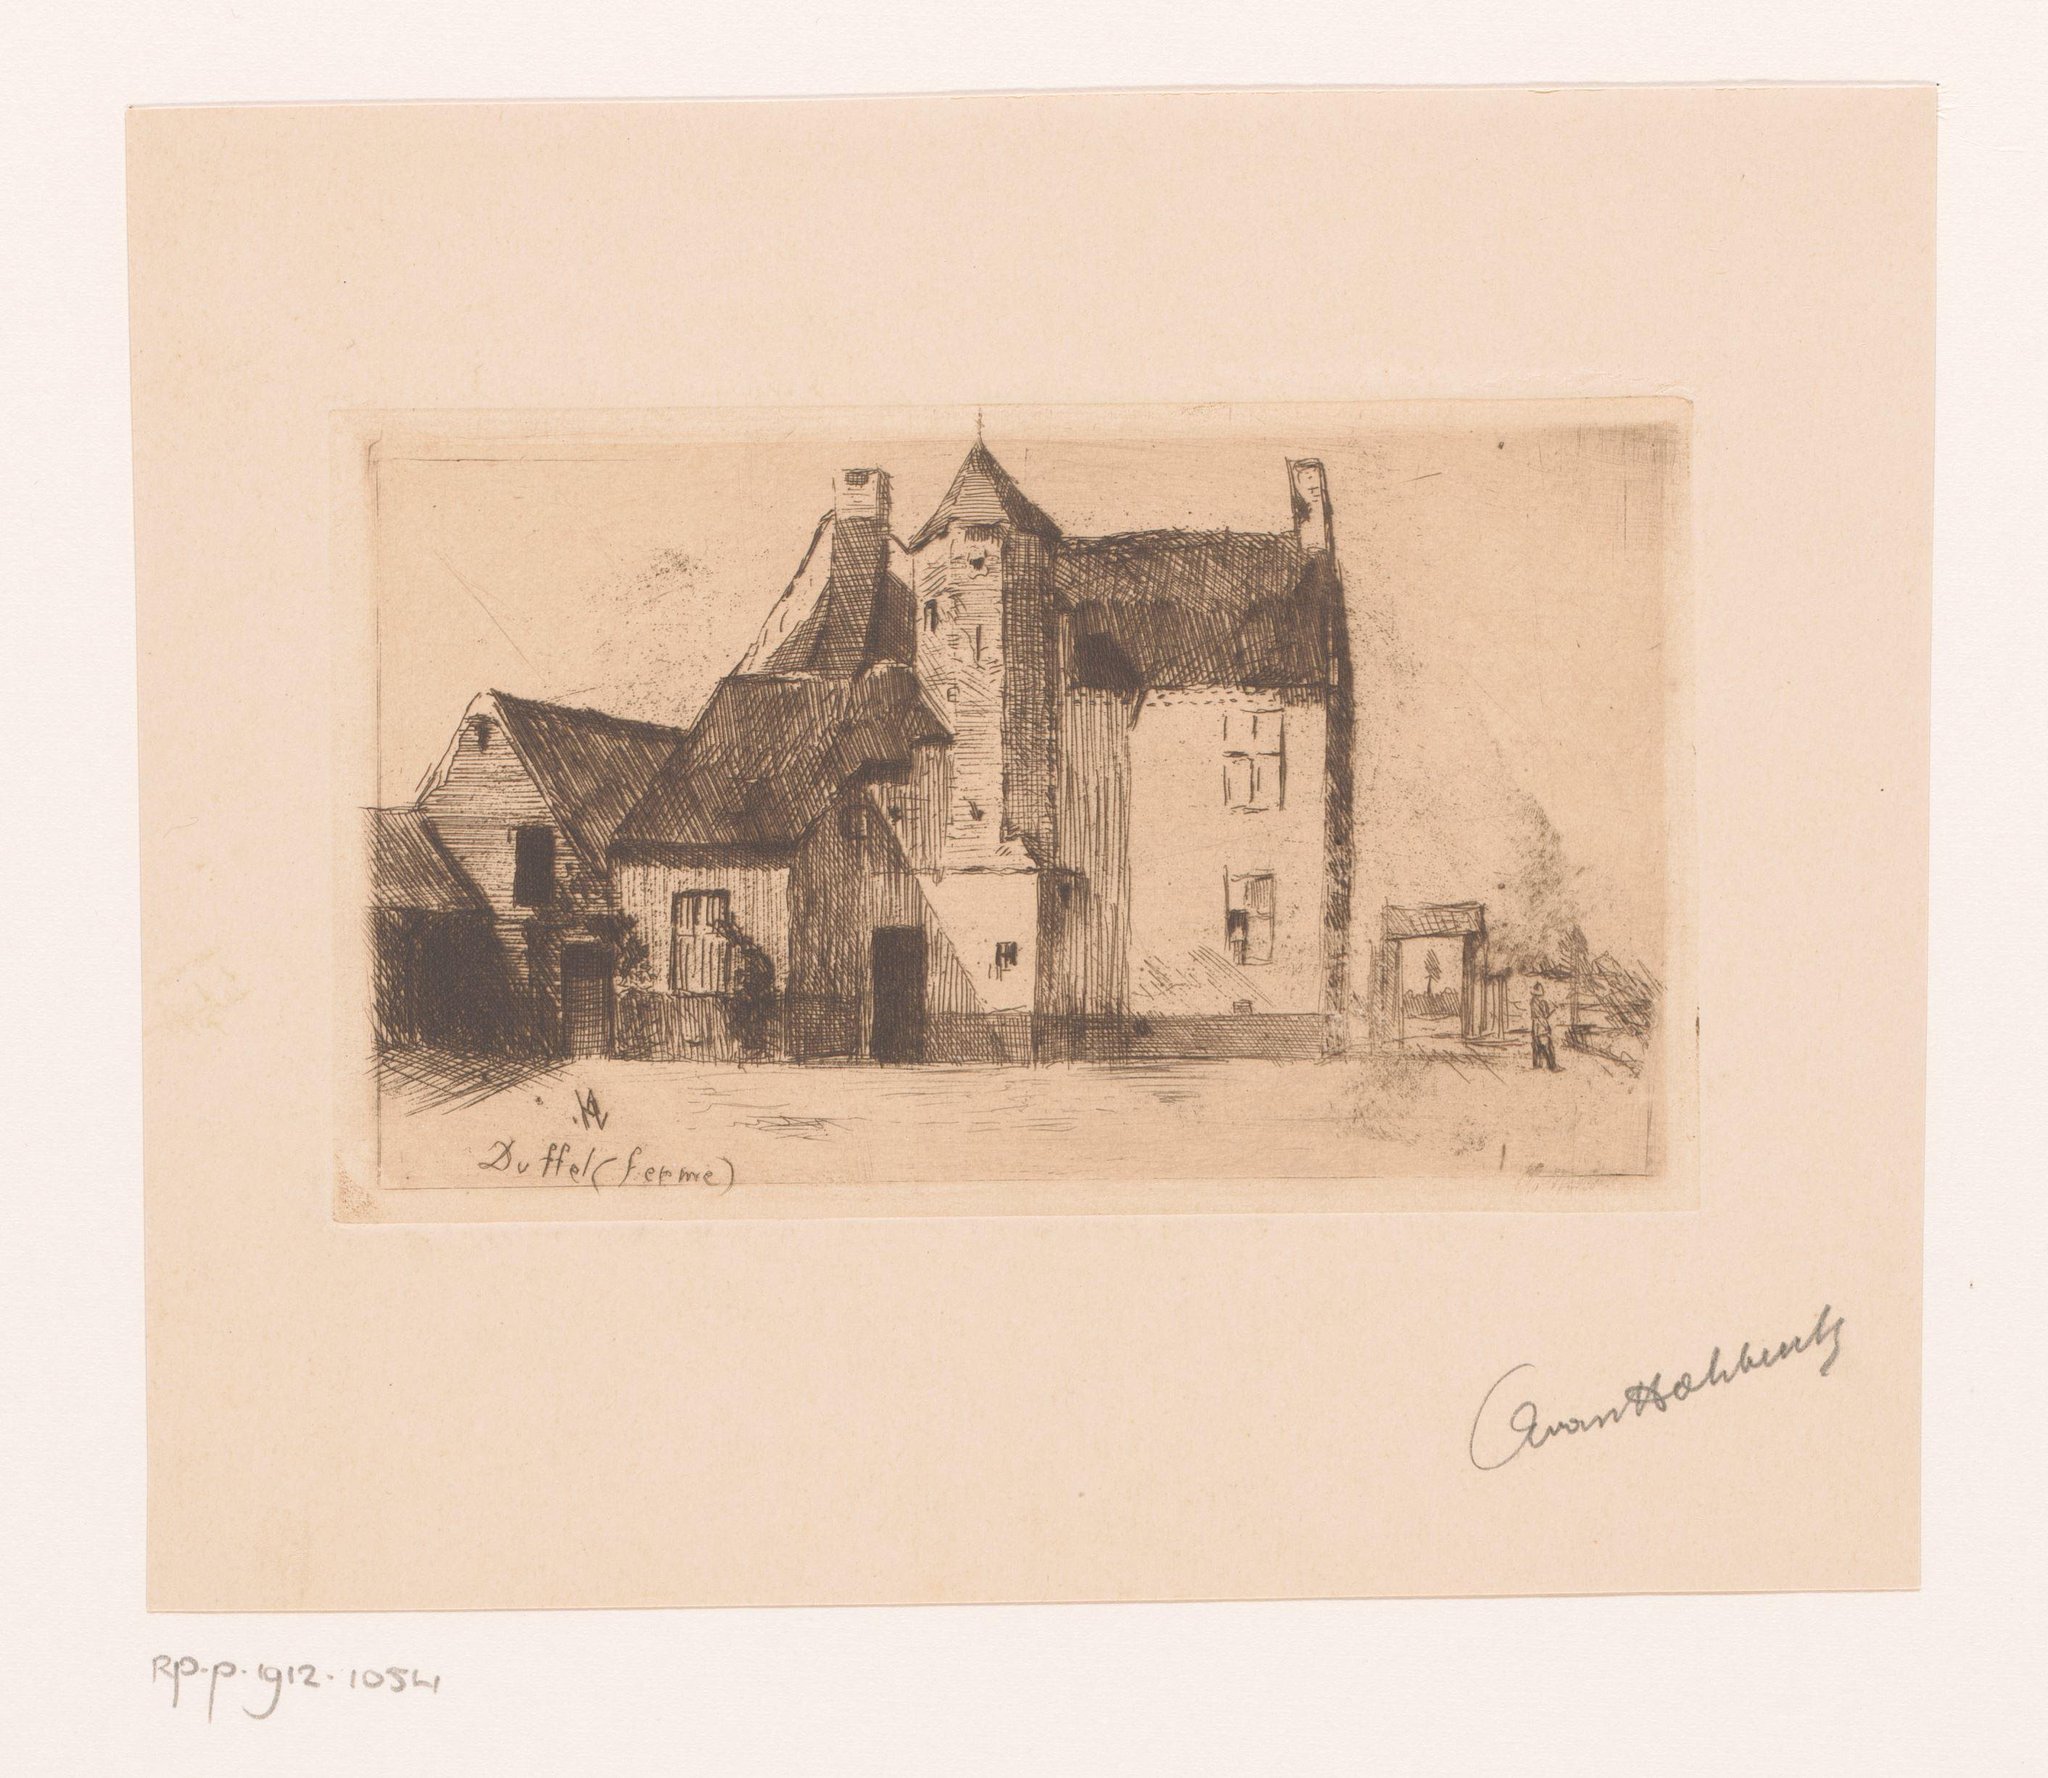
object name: print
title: Gezicht op een boerenhoeve in Duffel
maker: albert van holsbeeck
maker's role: print maker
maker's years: 1877-1948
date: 1887-1912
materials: paper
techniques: drypoint, etching, intaglio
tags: farm or solitary house in landscape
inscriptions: collector's mark: Lugt 2228